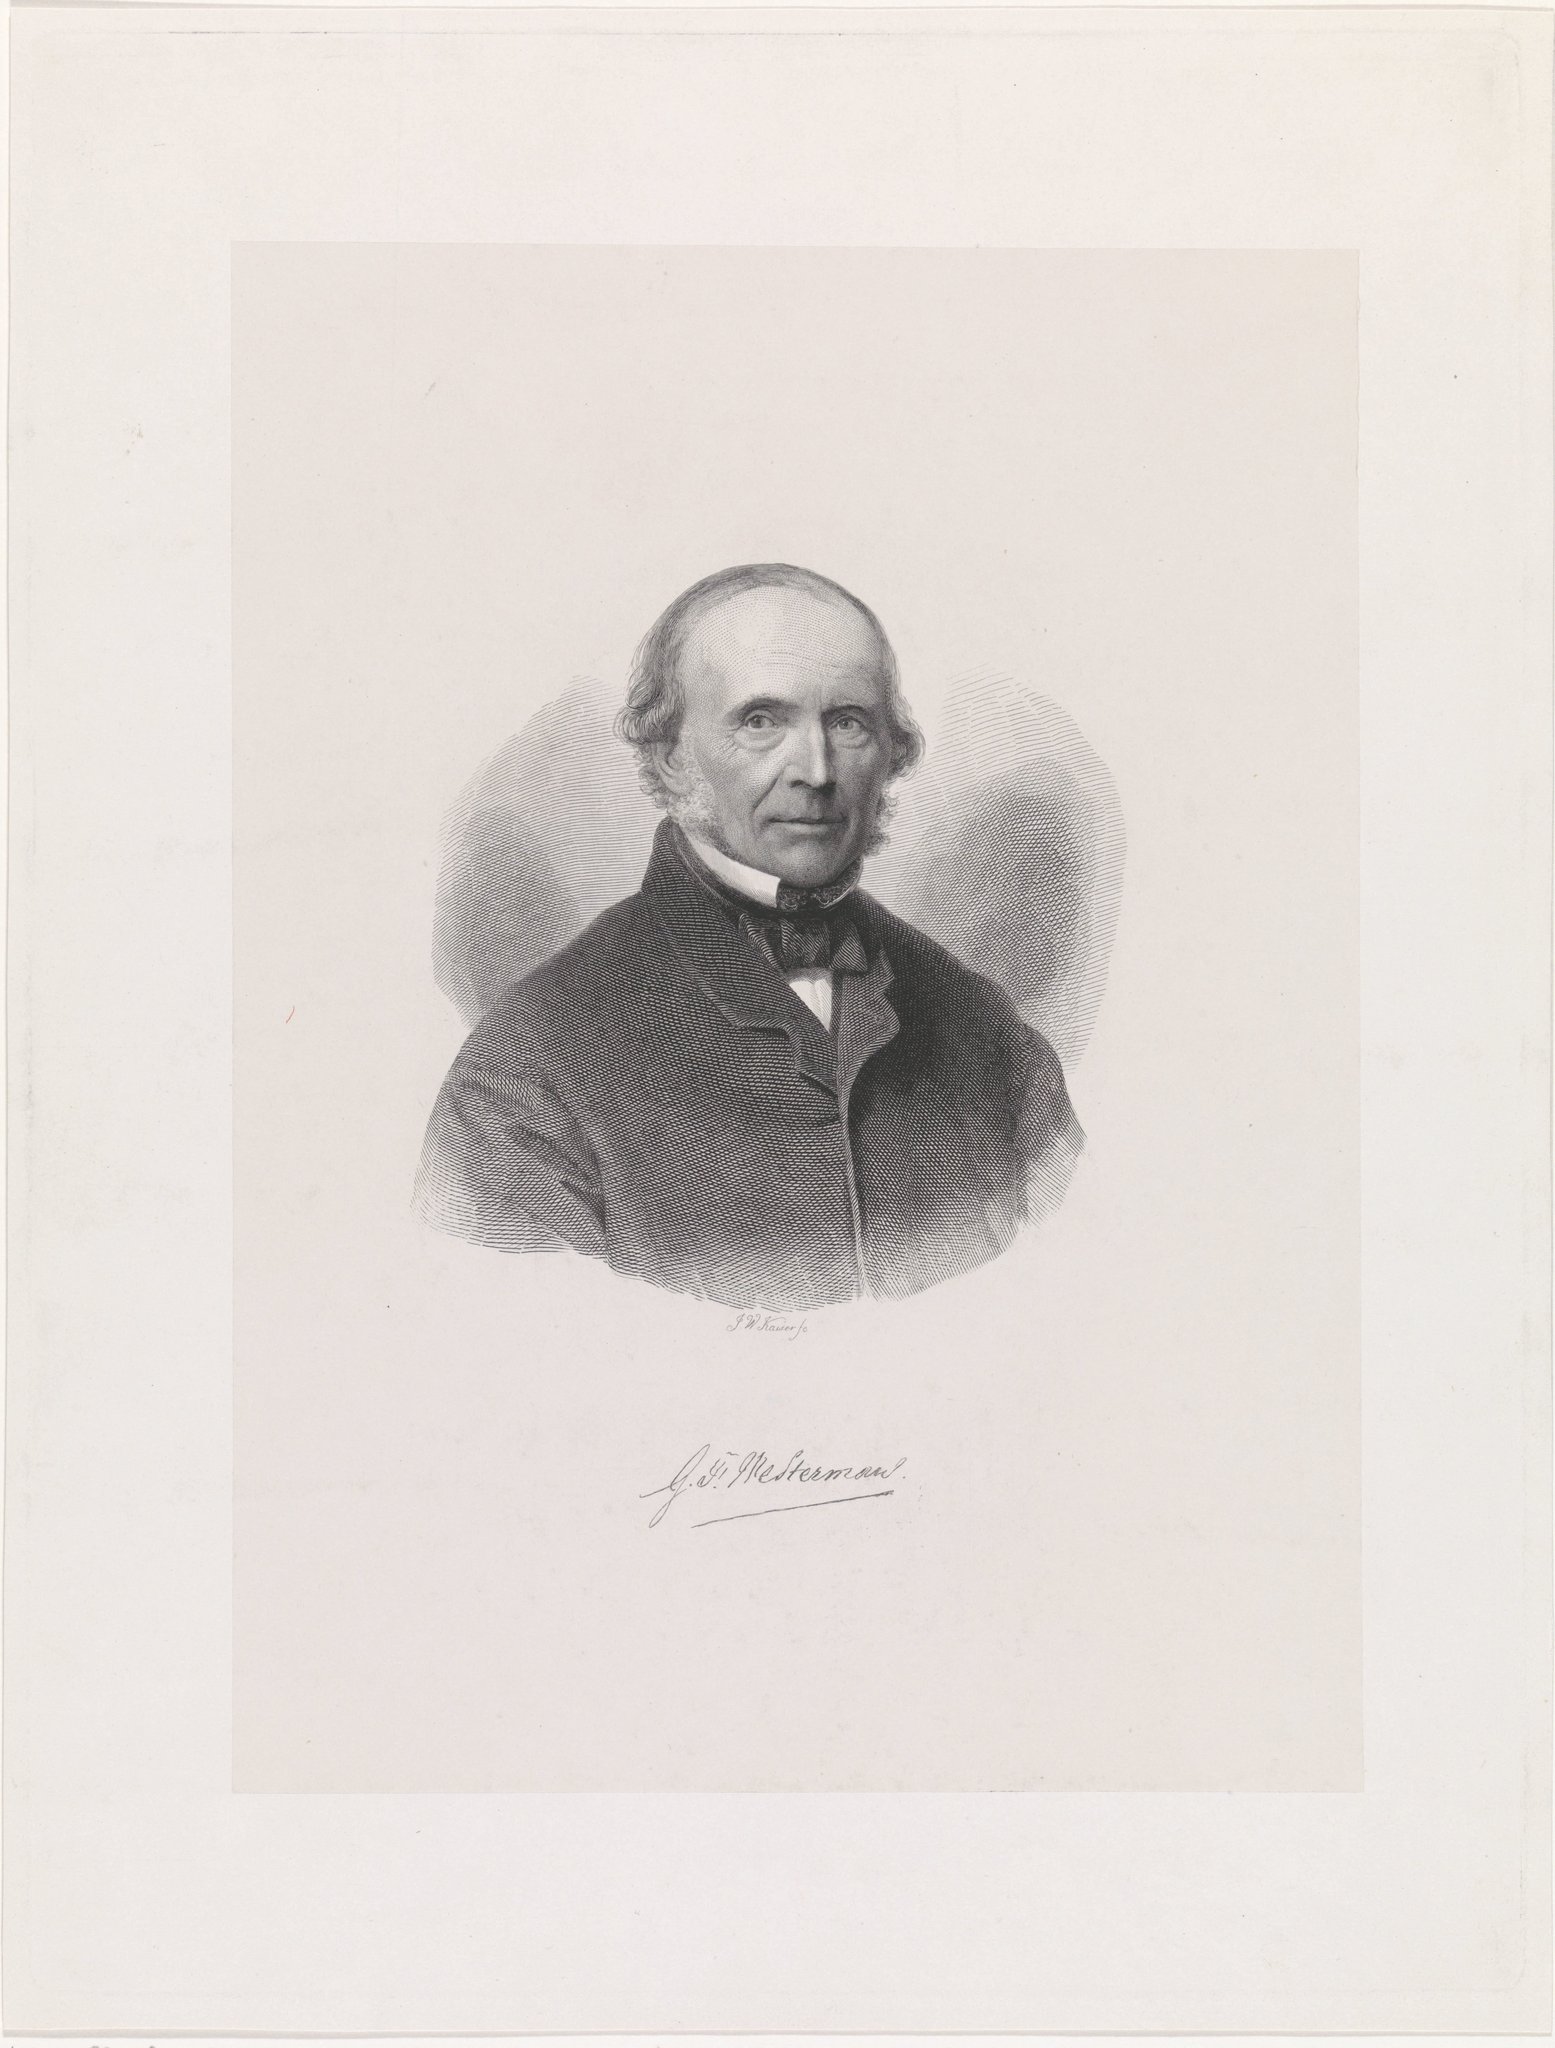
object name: print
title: Portret van G.F. Westerman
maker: johann wilhelm kaiser (i)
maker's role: draughtsman, print maker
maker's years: 1813-1900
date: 1823-1881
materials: paper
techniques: etching, roulette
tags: rotterdam, gerardus frederik westerman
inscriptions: collector's mark: Lugt 2228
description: Portretbuste naar rechts van G.F. Westerman, met jas en strik.